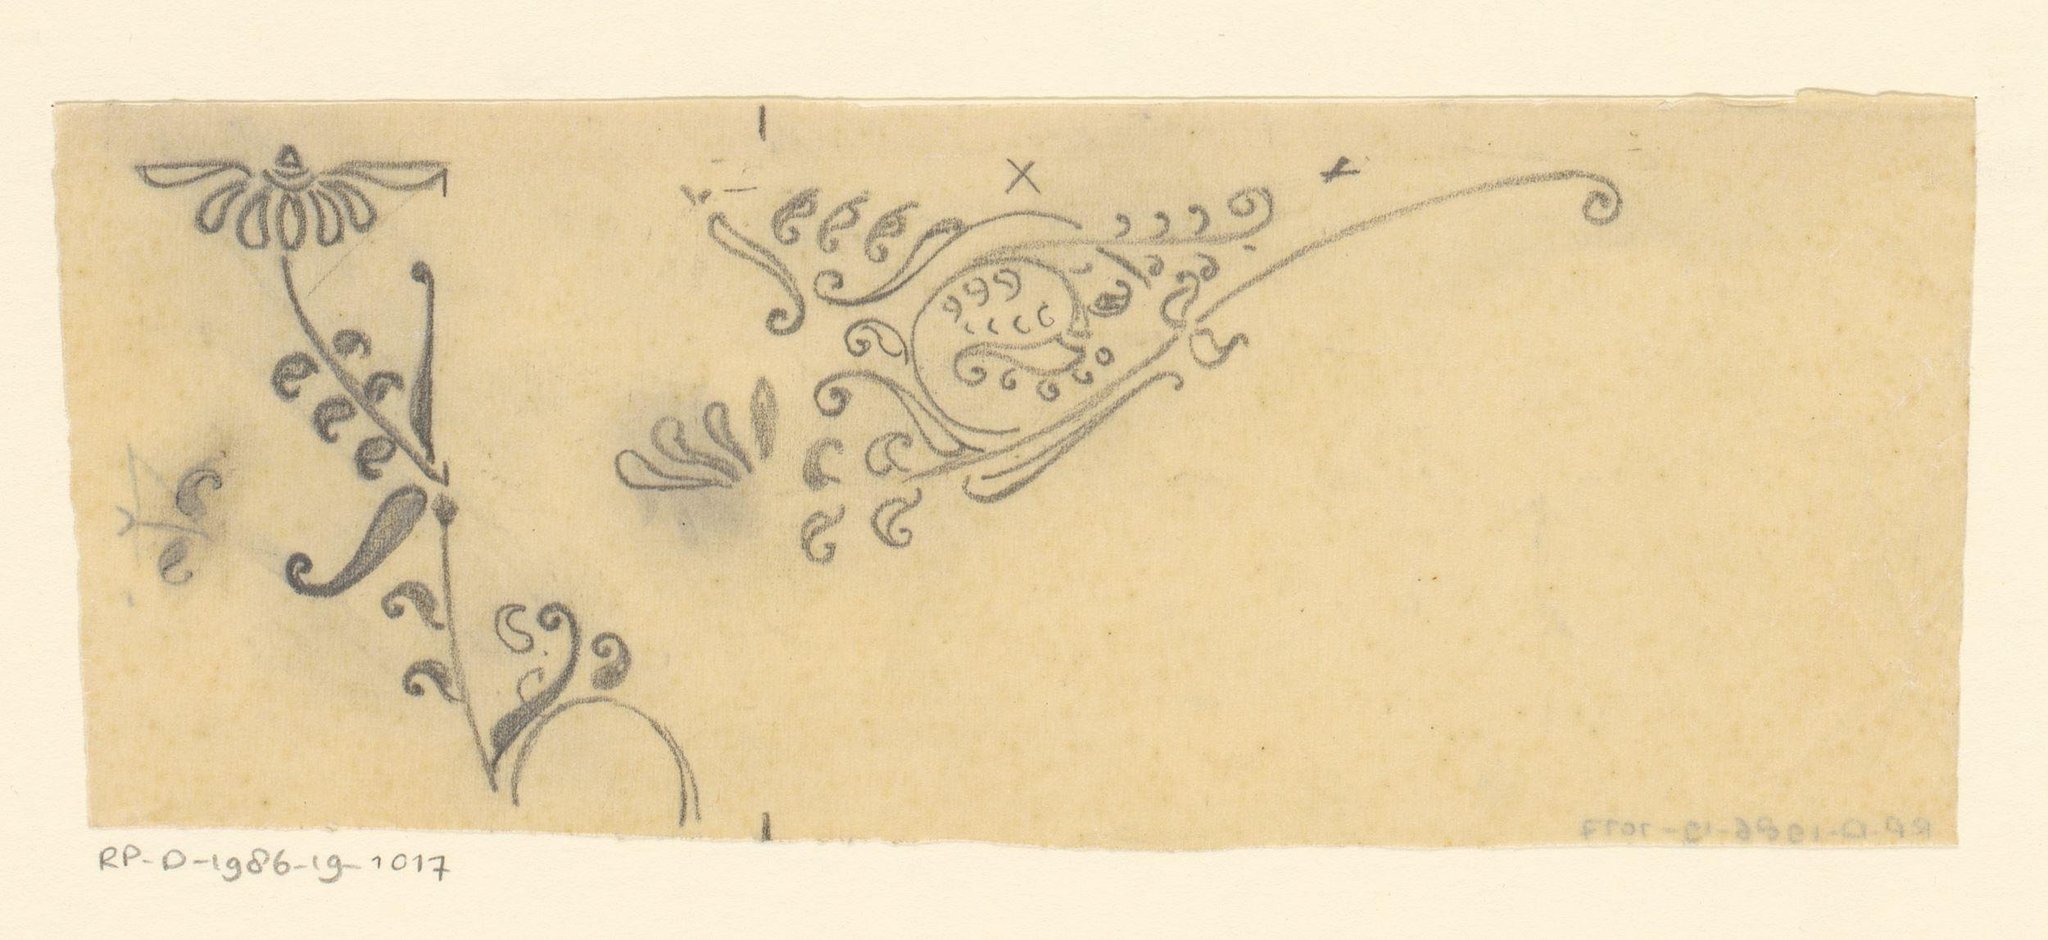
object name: drawing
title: Bloemornamenten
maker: reinier willem petrus de vries (1874-1953)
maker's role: draughtsman, print maker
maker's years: 1874-1953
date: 1884-1952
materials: pencil, paper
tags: flowers ~ ornament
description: Vermoedelijk een ontwerp voor: Ravesteijn, P.J. Gedenkboek Hilversum 1424-1924. Hilversum: Gemeente Hilversum, 1924.